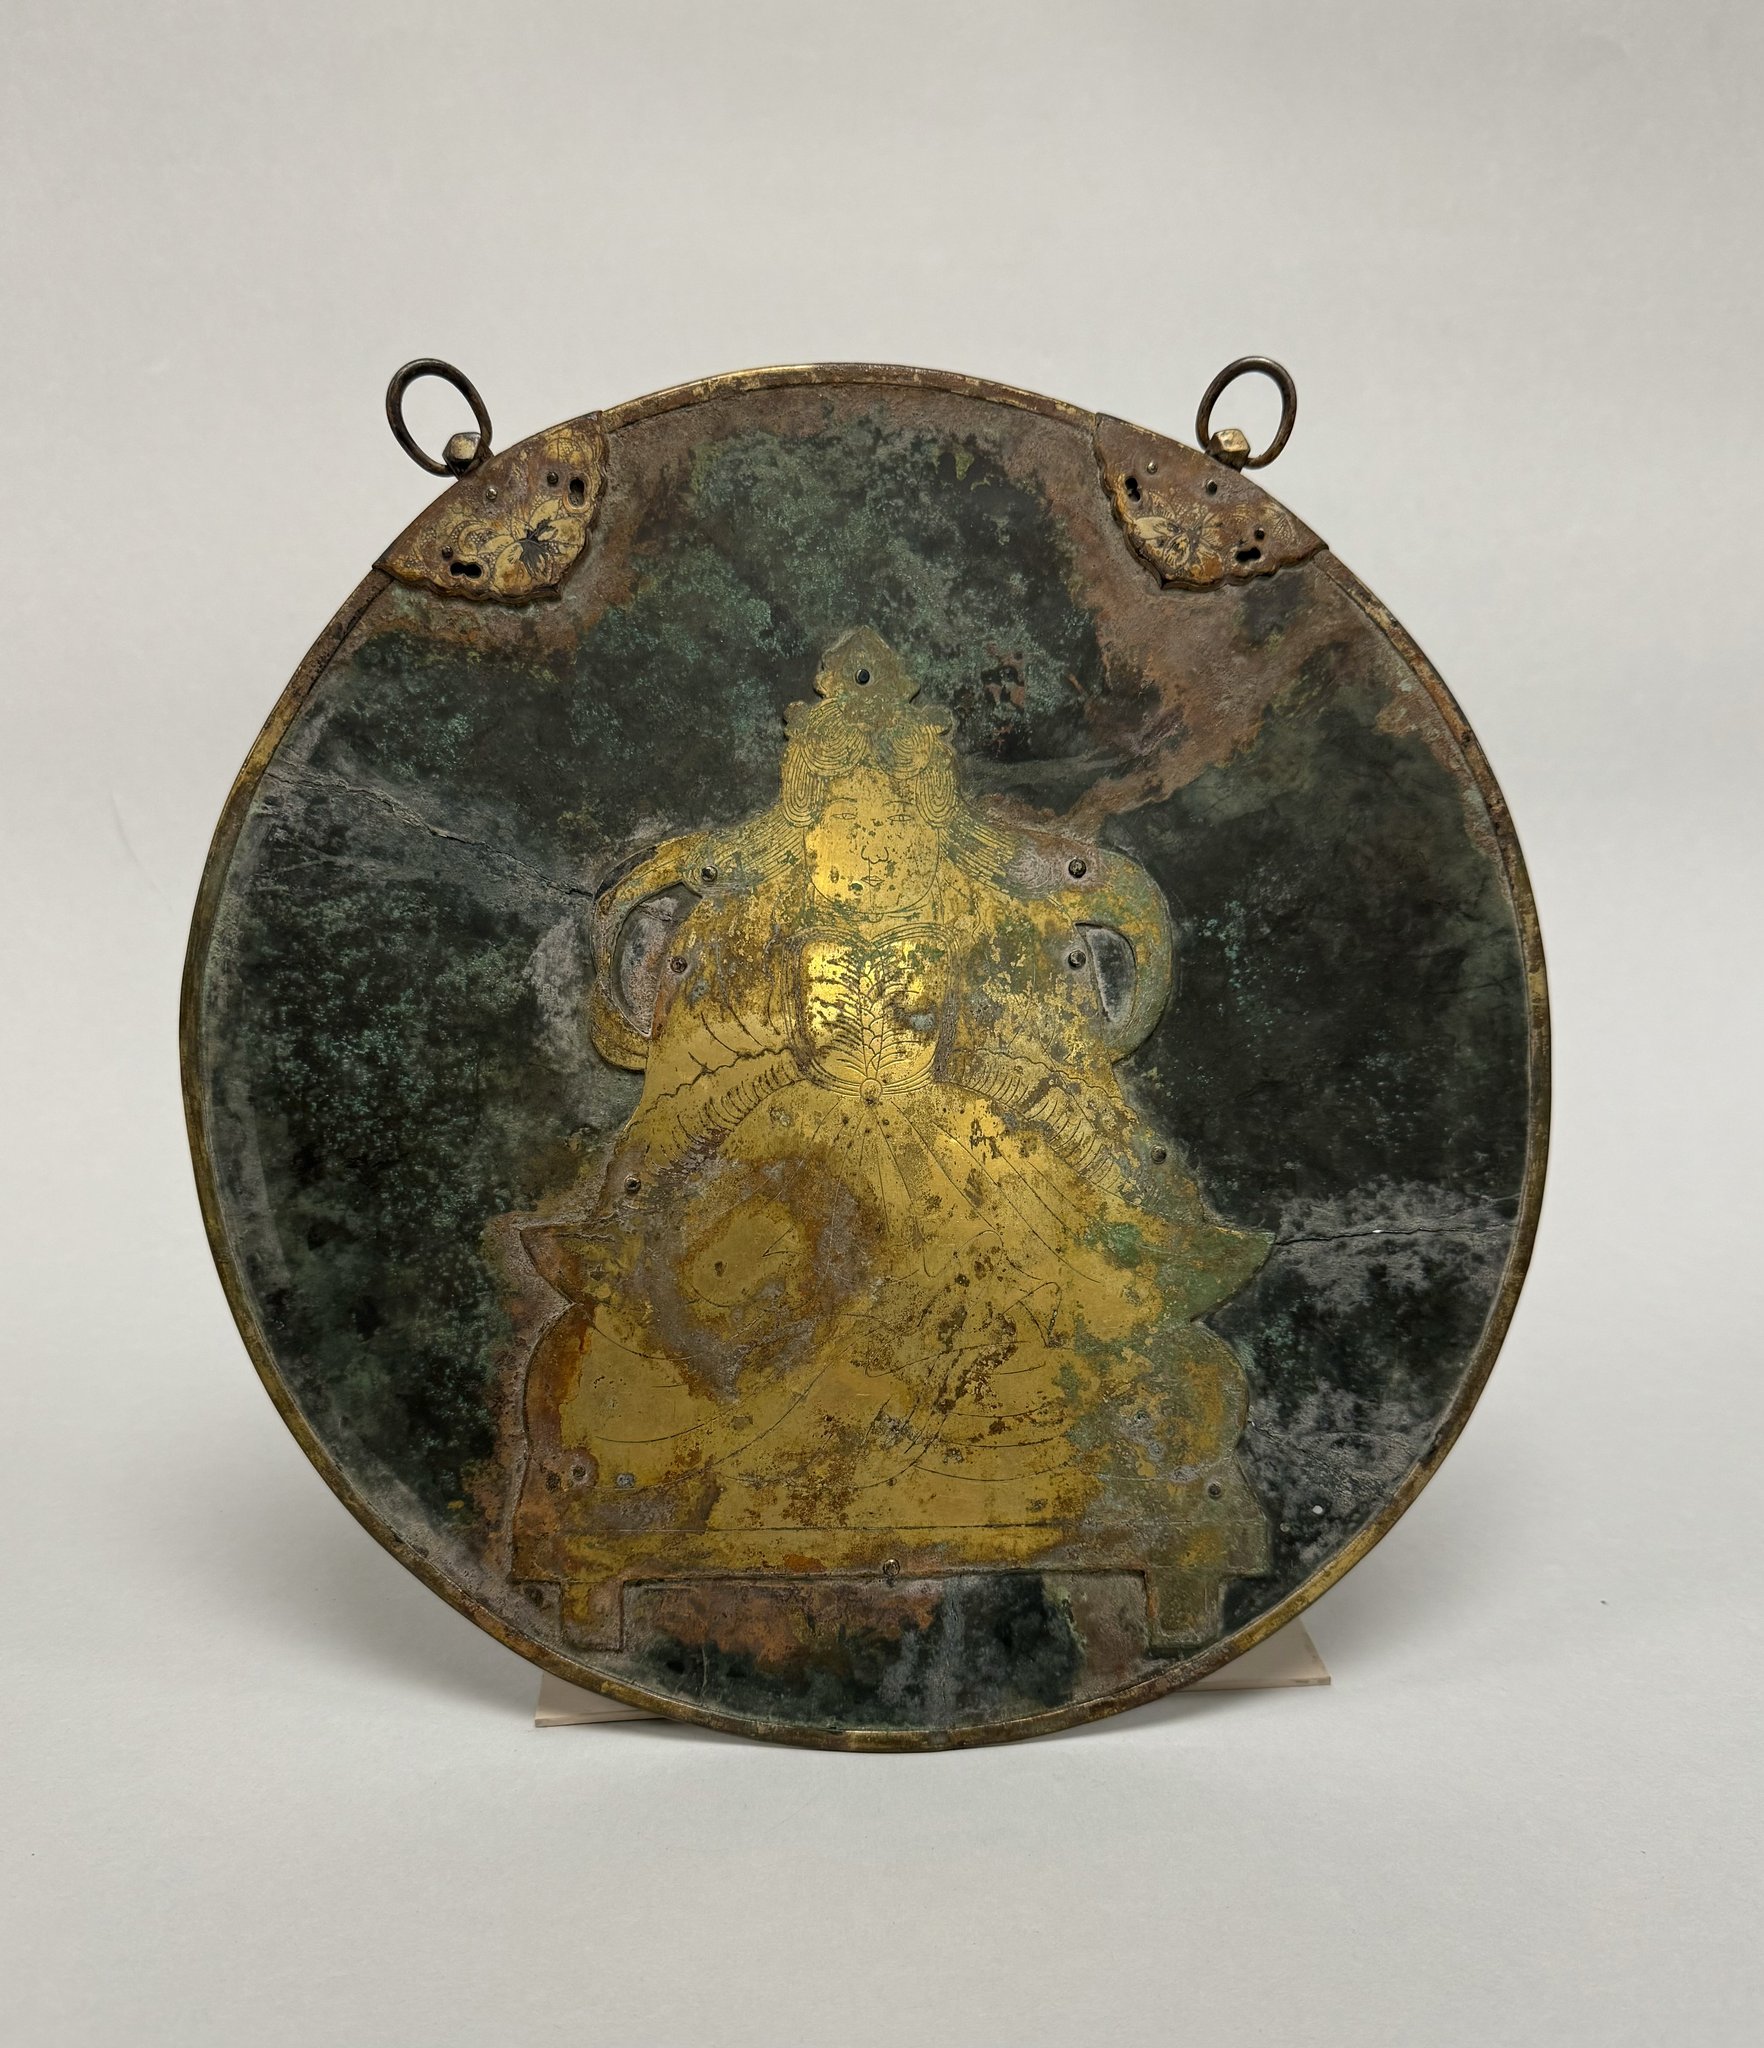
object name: disk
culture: japanese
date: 1392-1573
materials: gilt bronze, silver gilt